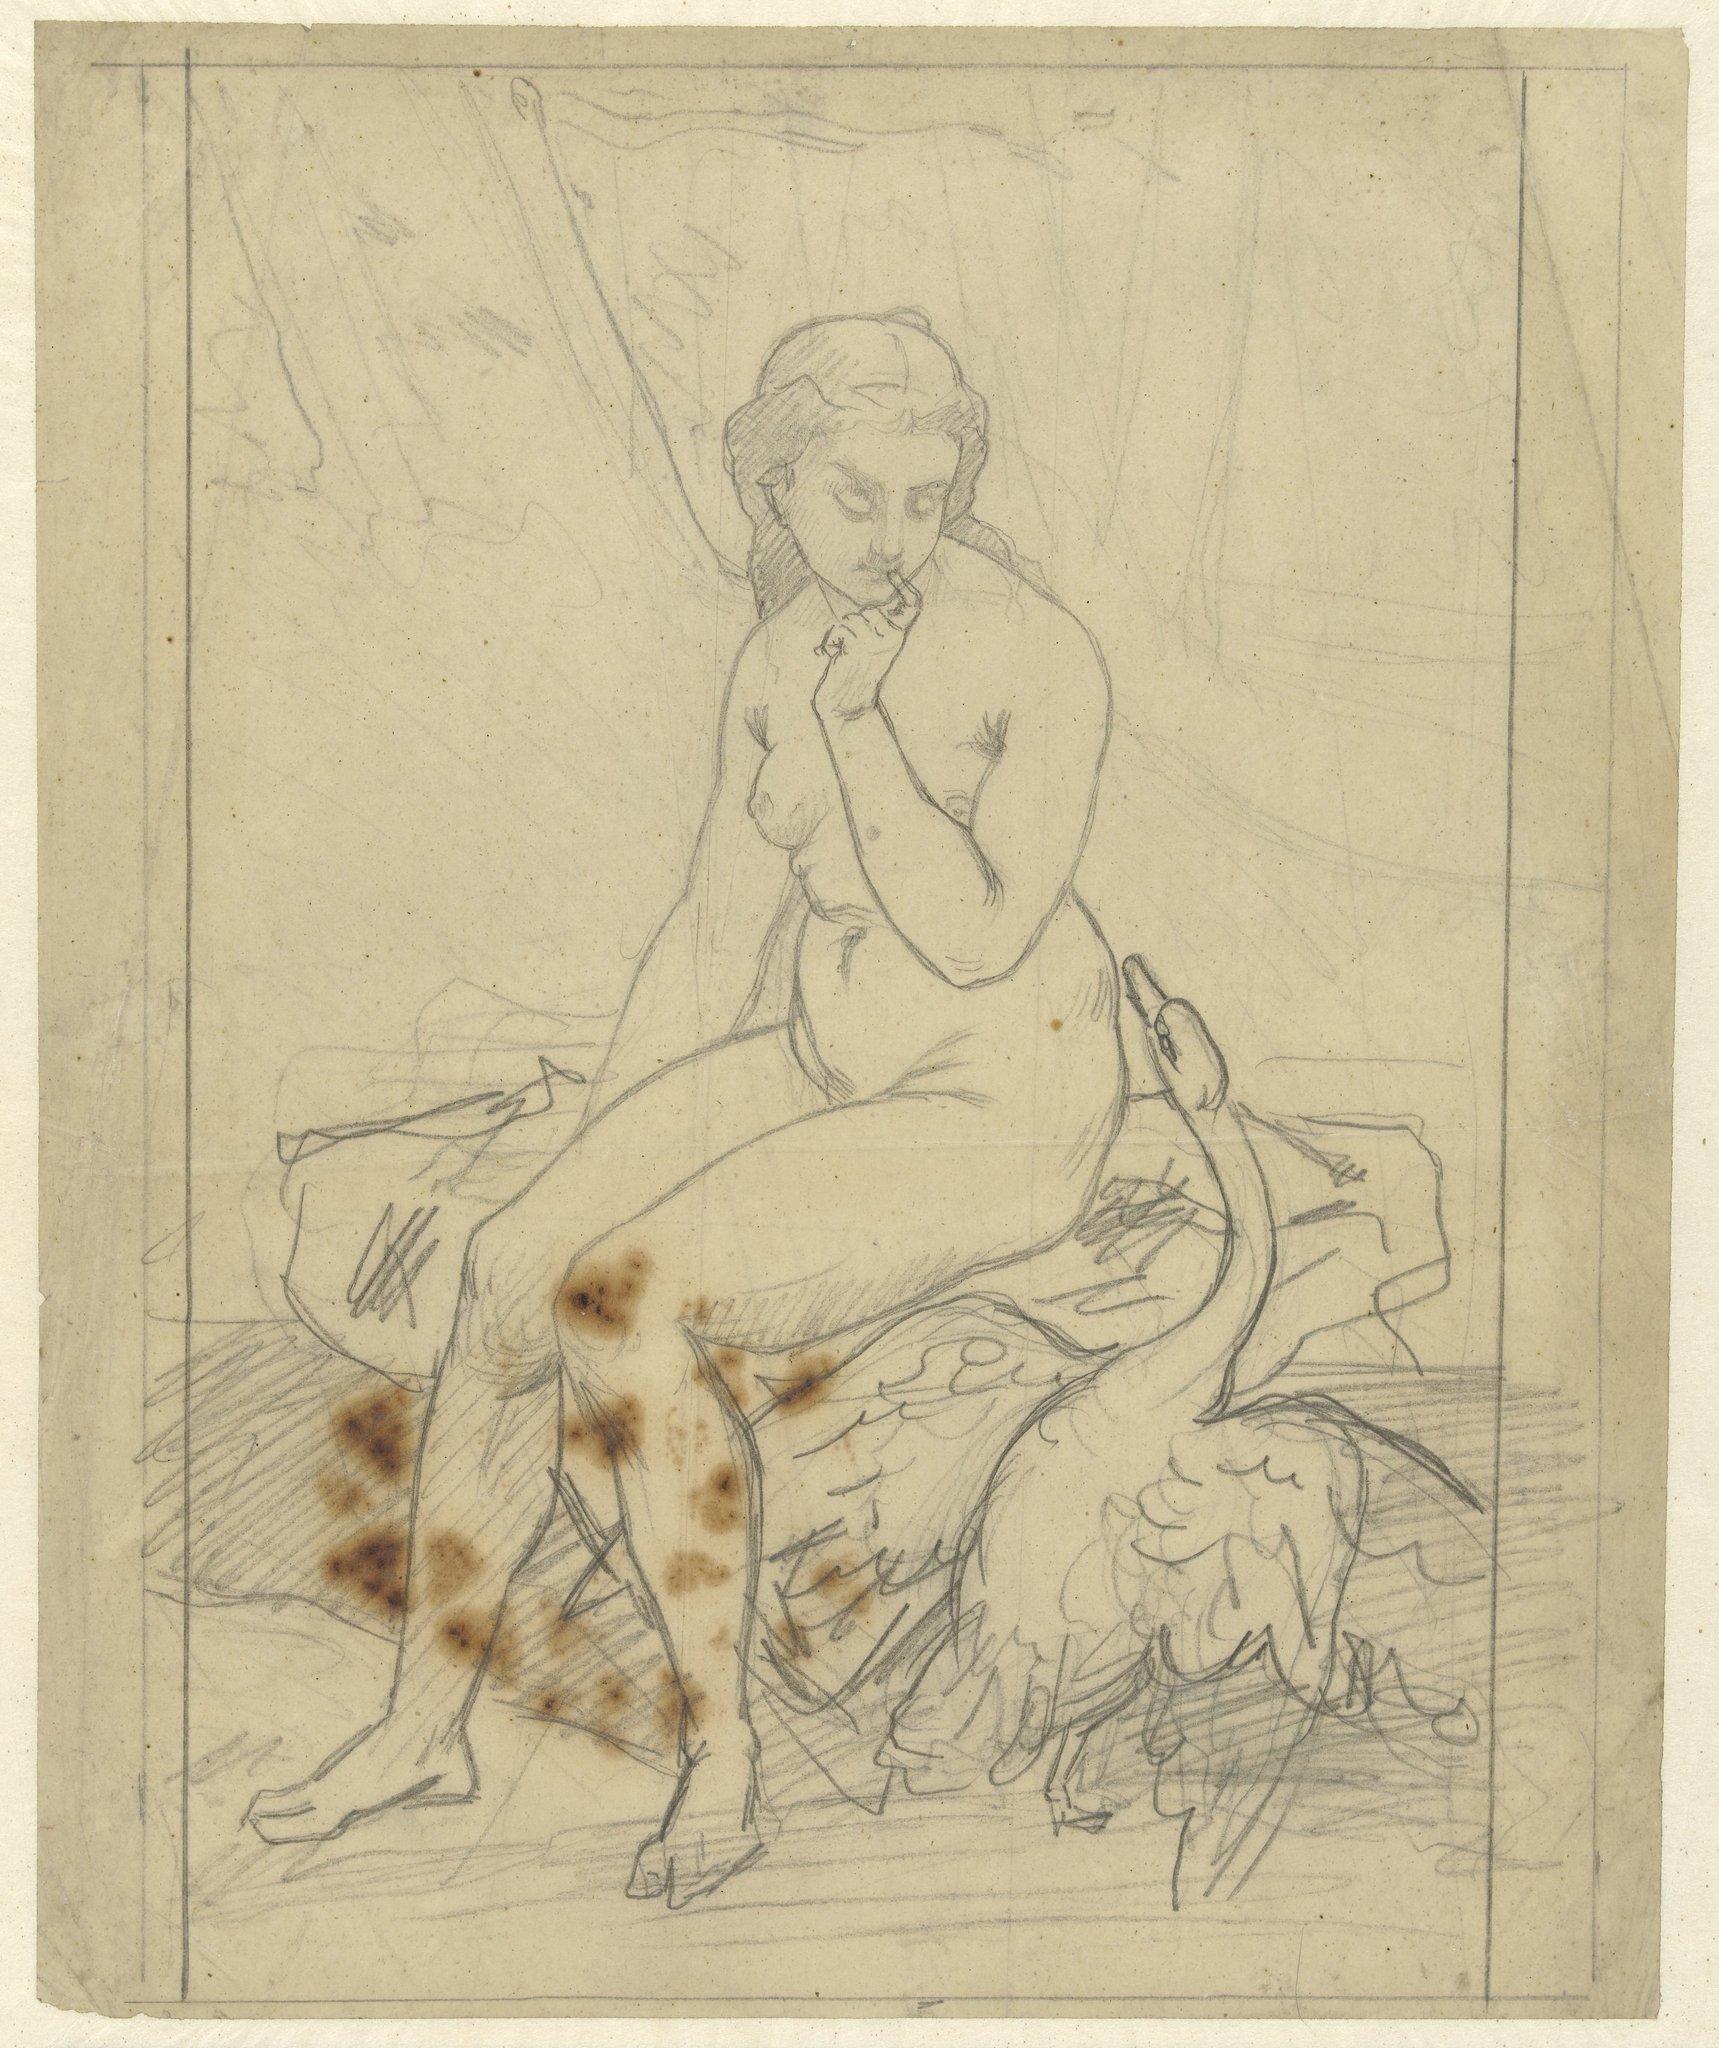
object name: drawing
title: Zittende Leda met de zwaan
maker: ferdinand roybet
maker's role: draughtsman, print maker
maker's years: 1840-1920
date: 1850-1920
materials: paper, pencil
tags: jupiter, in the shape of a swan, and leda